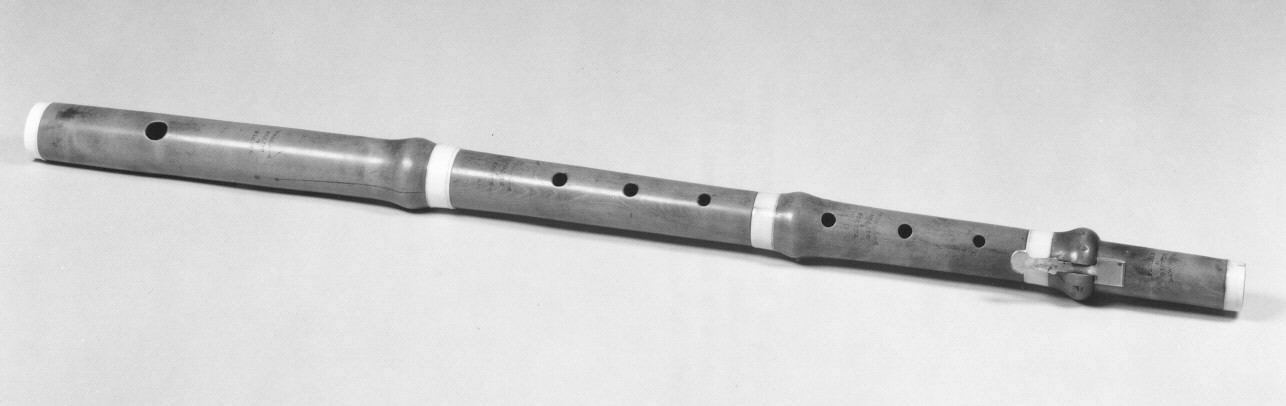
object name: flute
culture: american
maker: ferris & giffin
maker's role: maker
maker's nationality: american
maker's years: 1822-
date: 1822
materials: wood, ivory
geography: united states